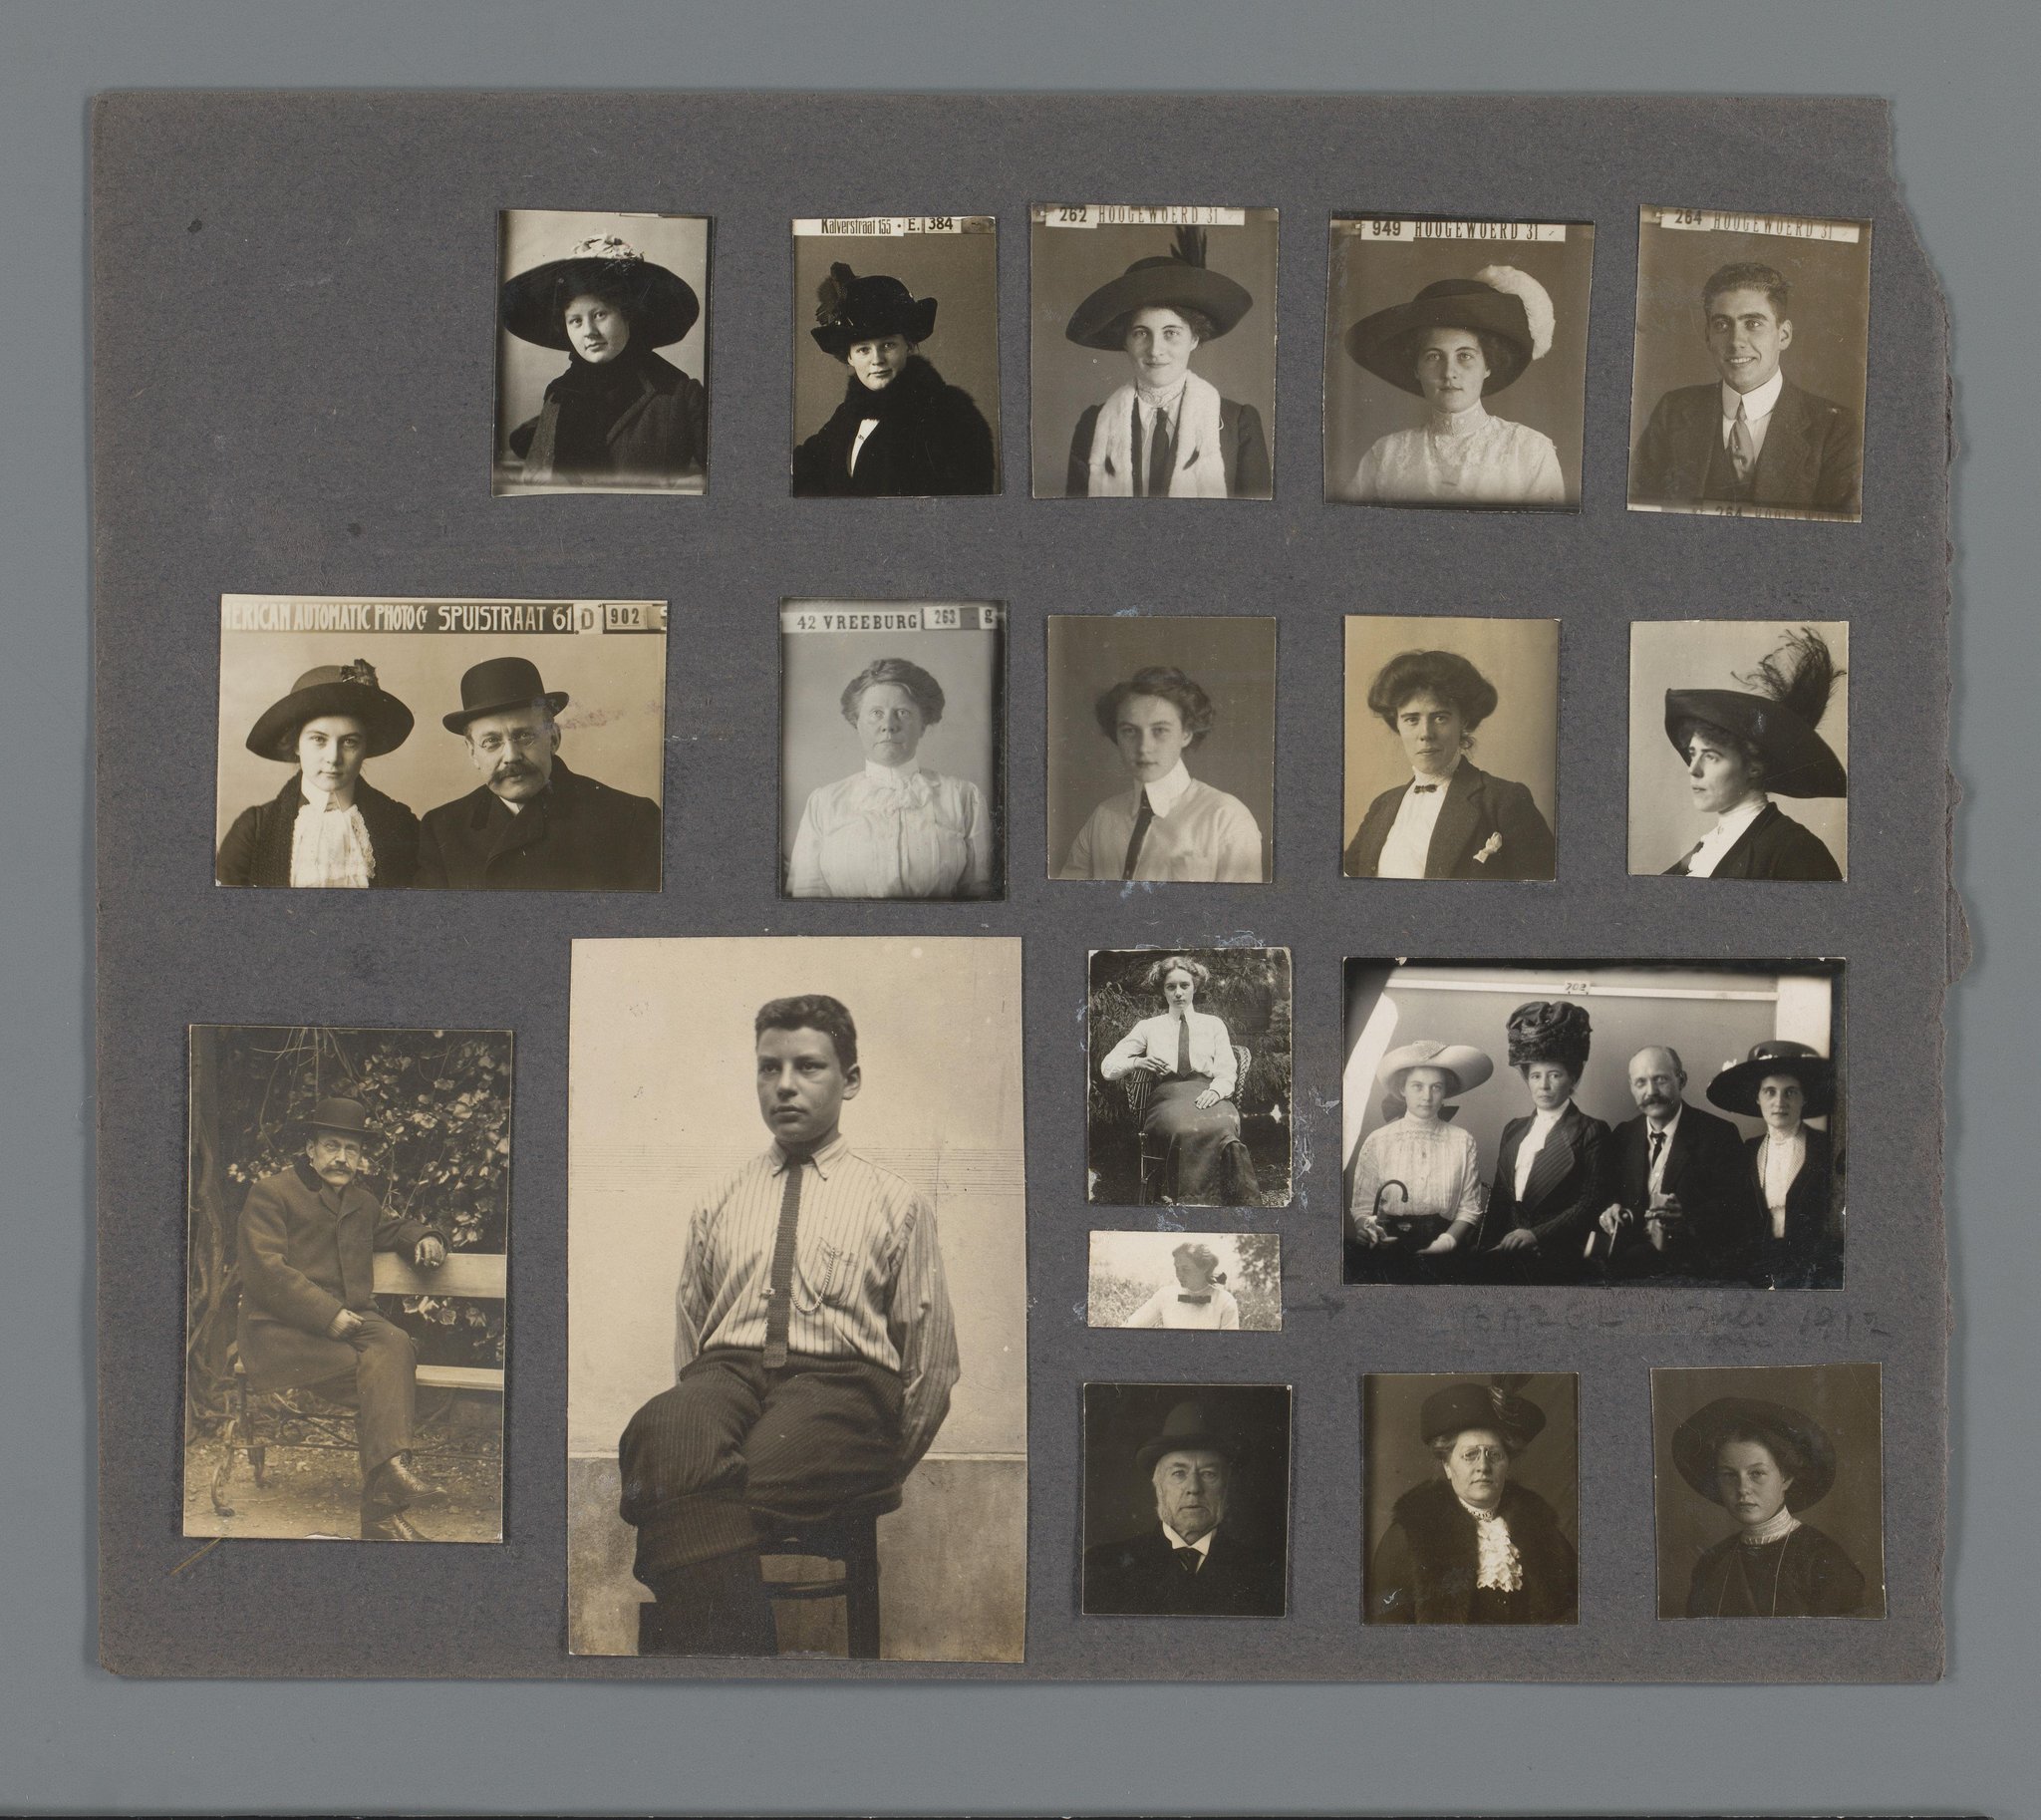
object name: photograph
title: Achttien portretten van mensen uit de omgeving van Willem en Piet de Jong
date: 1900-1918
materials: paper, cardboard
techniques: gelatin silver print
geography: the hague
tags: lambertus de jong, haarlem, elisabeth de jong-van tonderen, leiden, johanna petronella lambertina stokhuyzen-de jong (hans), johanna elisabeth borgerhoff mulder-vreede (nan), arnhem, hendrina johanna de jong-ploeg (dina), johan jacob borgerhoff mulder, frederik stokhuyzen (frits), willem de jong (fotograaf), historical persons, historical persons not known by name, netherlands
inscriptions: inscription: ‘Bazel juli 1912’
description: Van boven naar en onder en van links naar rechts zijn geportretteerd: een onbekende vrouw twee keer, Johanna (Nan) Elisabeth Vreede twee keer, Johan Jacob Borgerhoff Mulder, Johanna (Hans) de Jong met Willem de Jong, een onbekende vrouw, Johanna (Hans) de Jong, Arnolda Anthonia (Tonny) Lechner twee keer, Willem de Jong, Frederik (Frits) Stokhuyzen, Johanna (Hans) de Jong, Johanna (Hans) de Jong met haar stiefmoeder mevrouw De Jong en Willem de Jong en Johanna (Nan) Vreede, Johanna (Hans) de Jong in Bazel in 1912, Lambertus de Jong, Hendrina (Dina) de Jong-Ploeg en een onbekende vrouw.